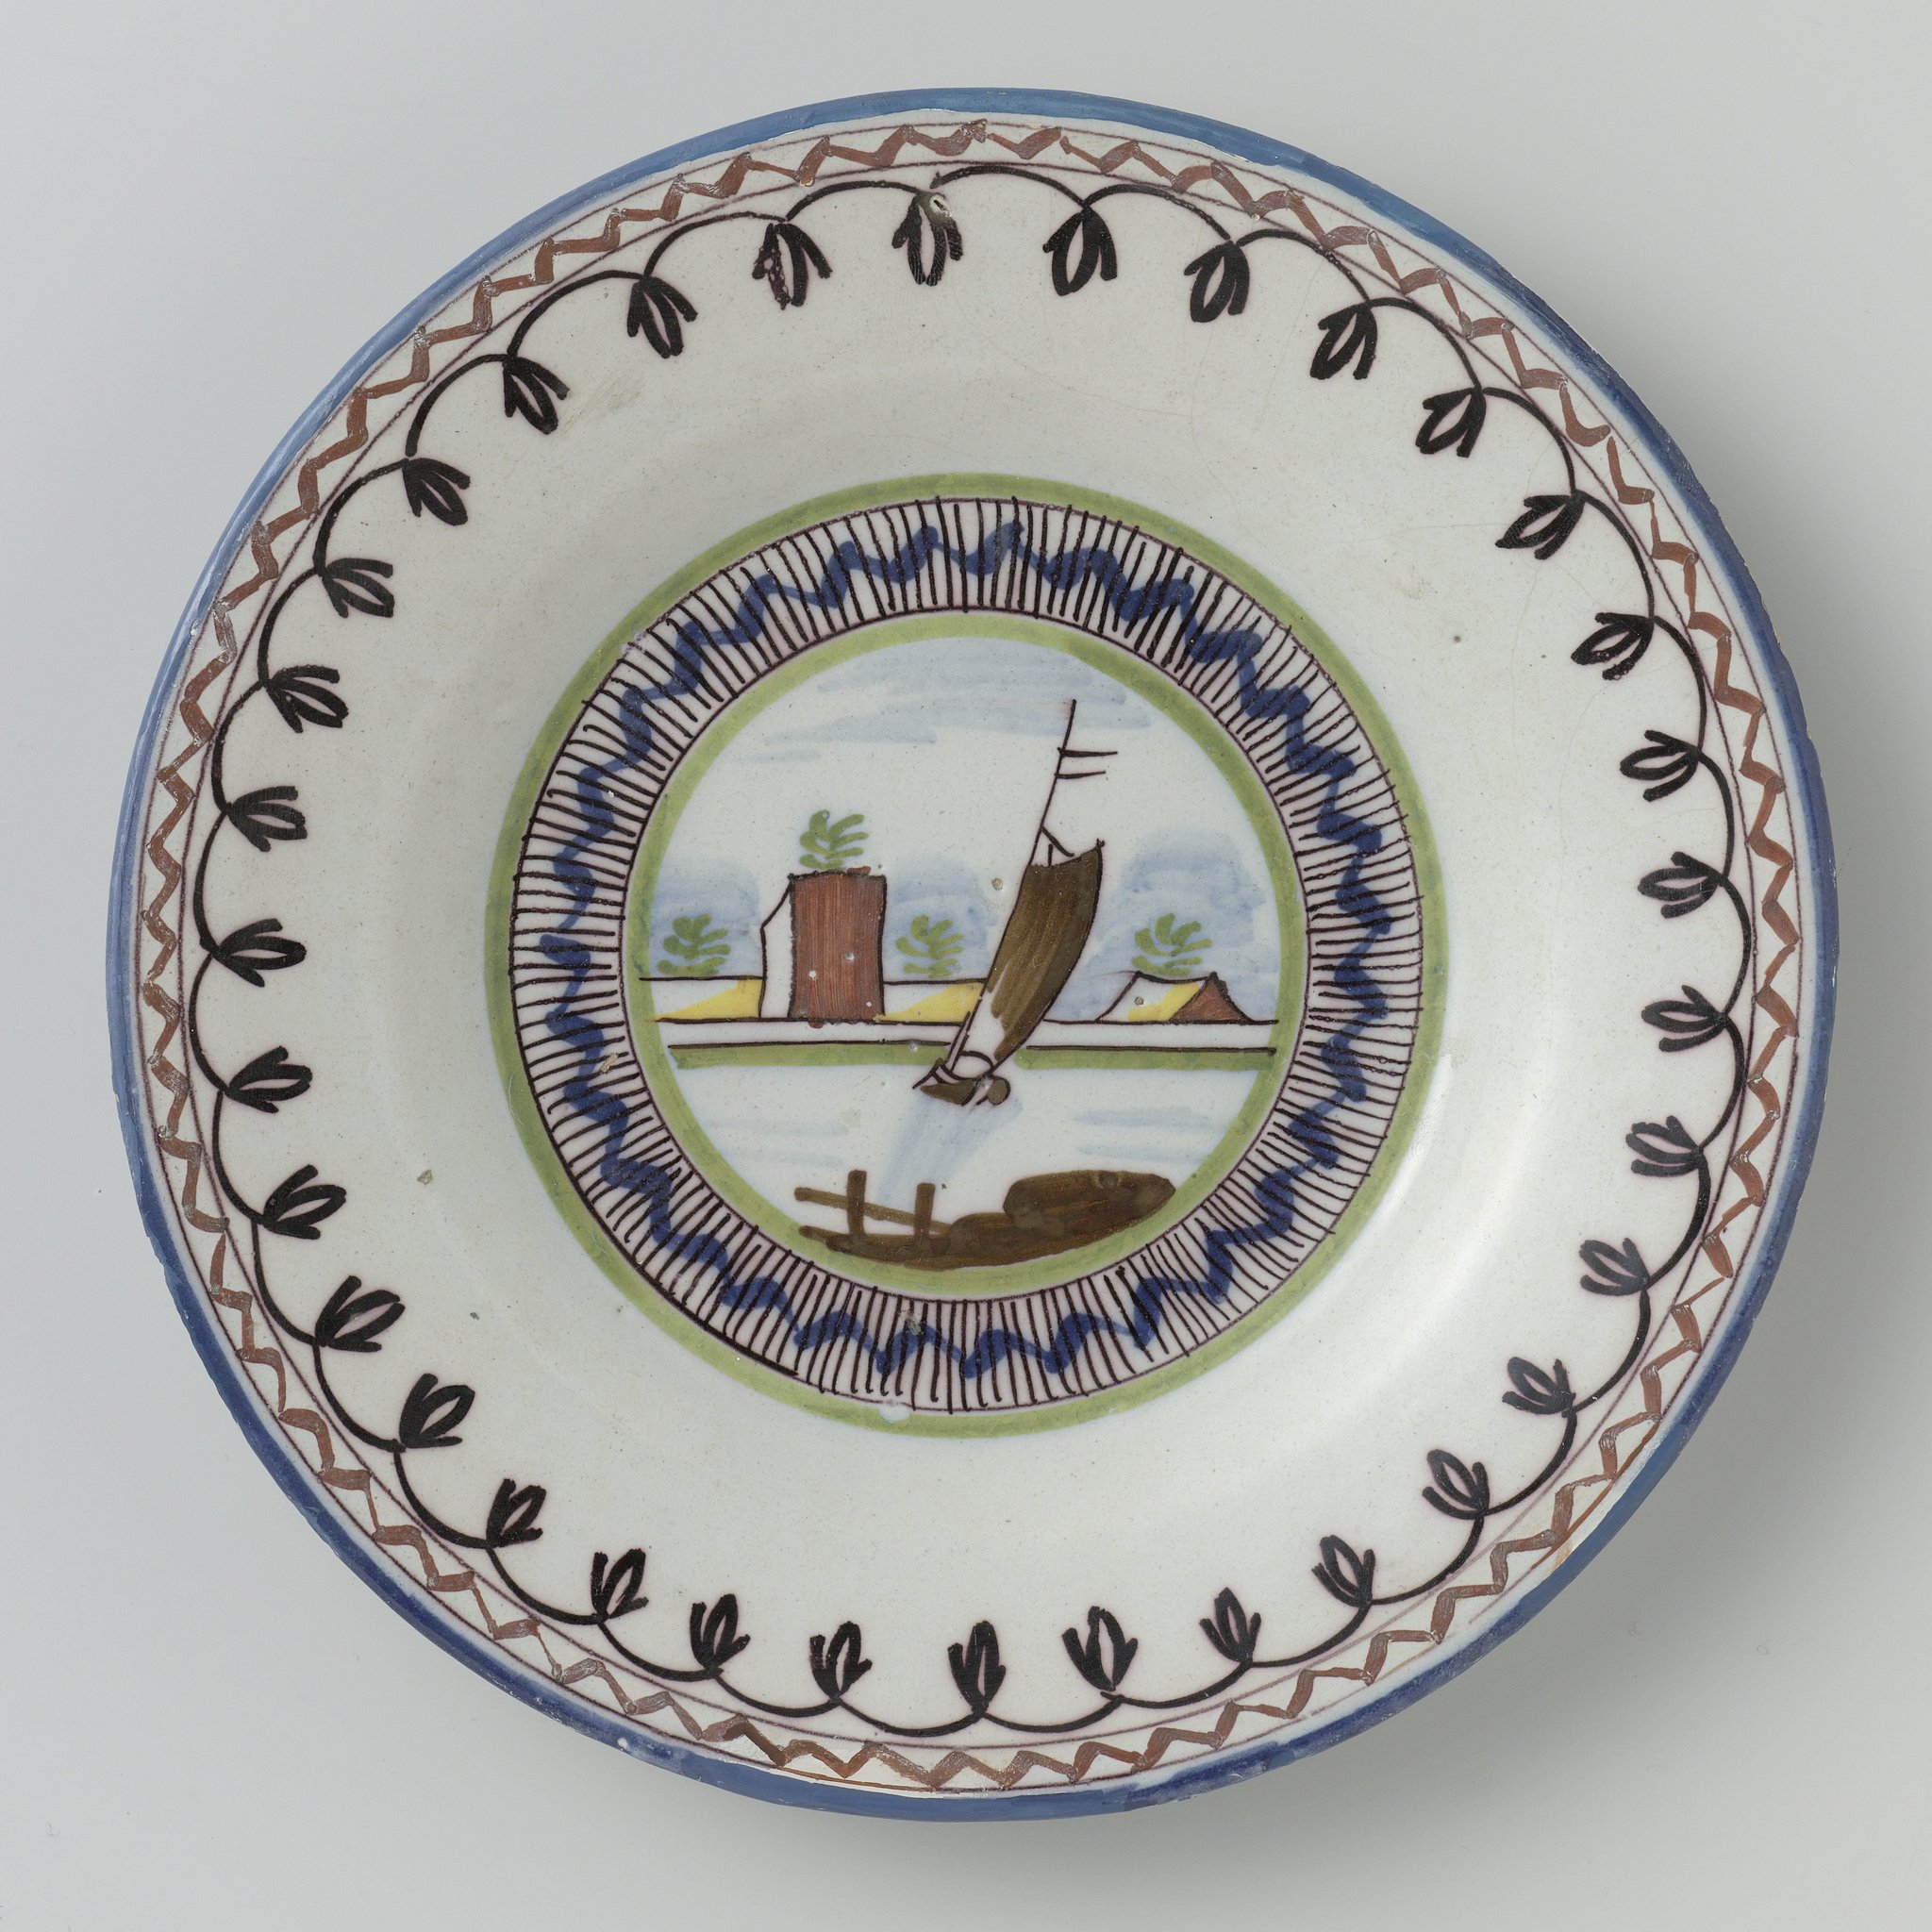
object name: plate dish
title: Bord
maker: Anonymous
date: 1770-1820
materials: earthenware, glaze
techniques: painted, polychromy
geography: delft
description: Rond bord van veelkleurig beschilderde faience, met op het plat een zeilende boot en een landschap. Bij het bord hoort een identiek bord met invnr. BK-NM-4226.